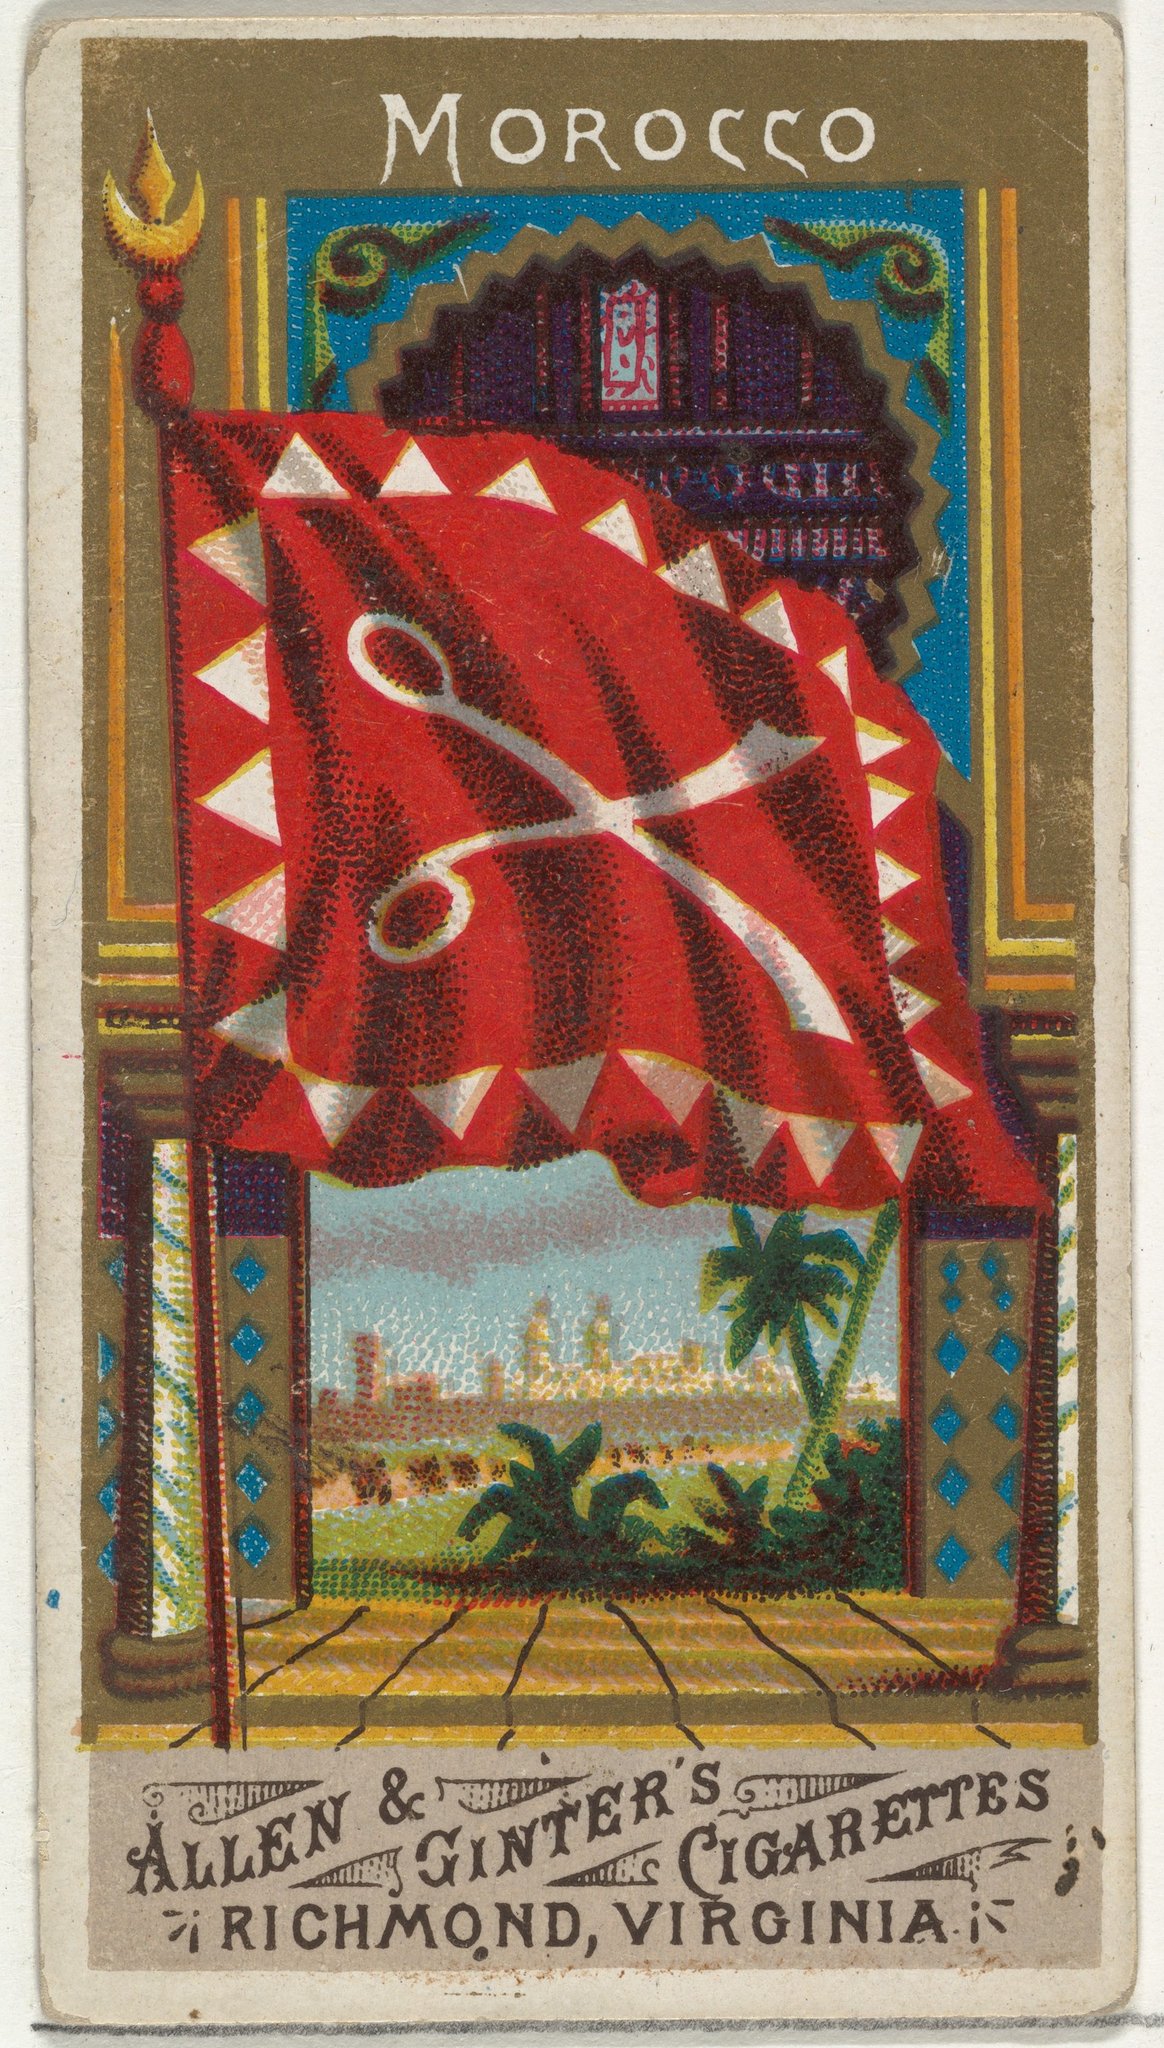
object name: print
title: Morocco, from Flags of All Nations, Series 1 (N9) for Allen & Ginter Cigarettes Brands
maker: allen & ginter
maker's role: publisher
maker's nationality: american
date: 1887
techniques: color lithograph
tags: flags